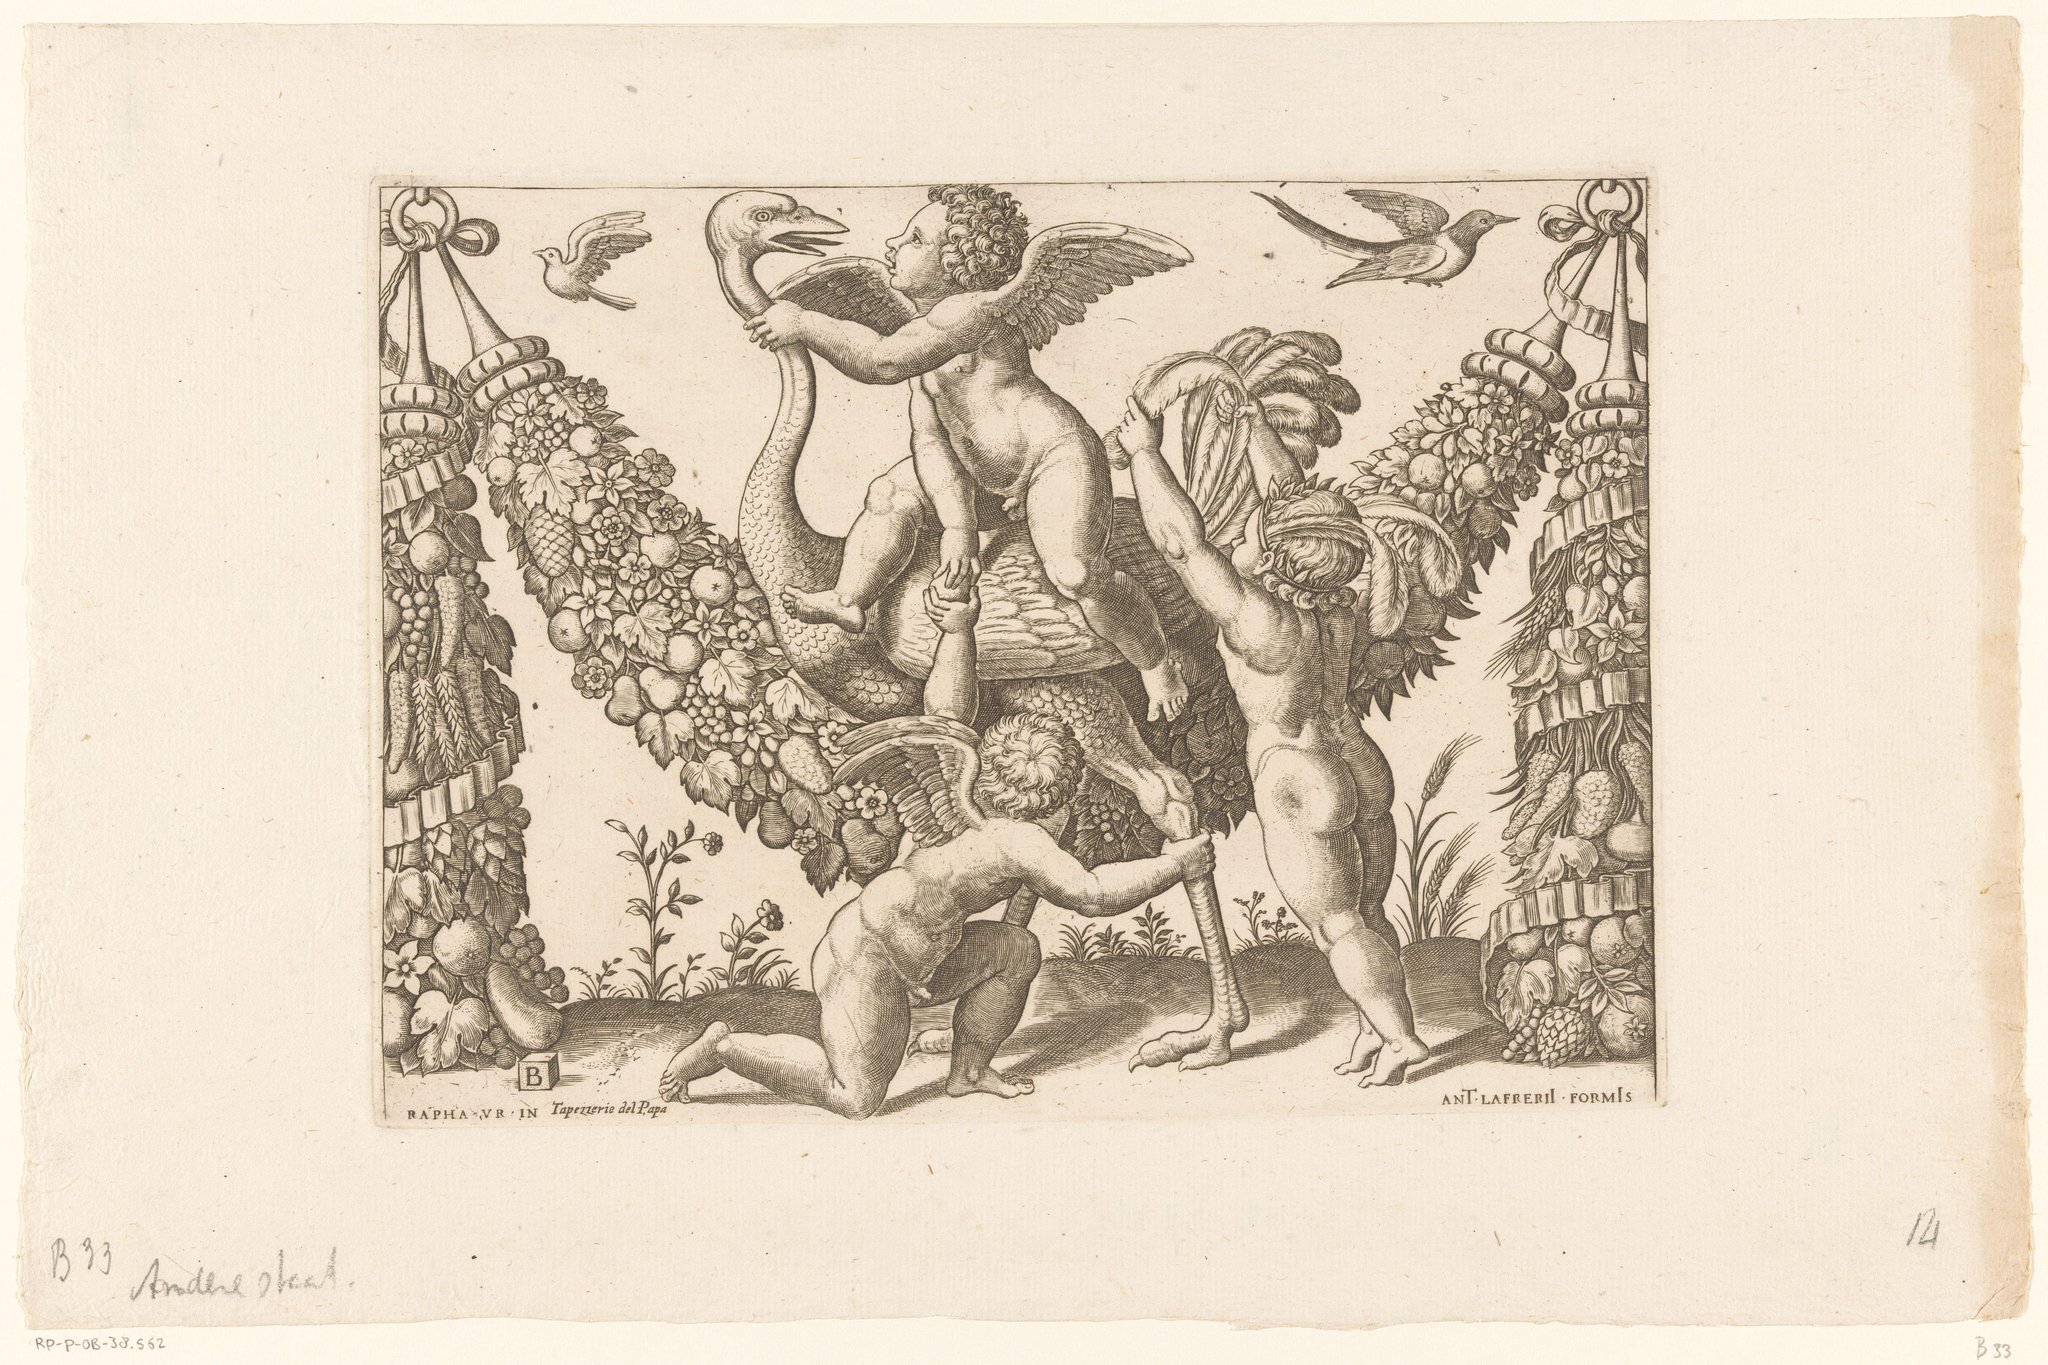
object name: print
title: Tapisserieën van de paus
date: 1530-1560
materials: paper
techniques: engraving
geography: rome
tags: walker and runner birds: ostrich, cupids: 'amores', 'amoretti', 'putti'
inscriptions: collector's mark: Lugt 2228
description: Voor een grote guirlande zit een putto op een struisvogel. Een andere putto houdt de poot van de struisvogel vast en geeft een vrucht aan de putto die op de vogel zit. Een derde putto draagt een verentooi en trekt een veer uit de staart van de vogel.